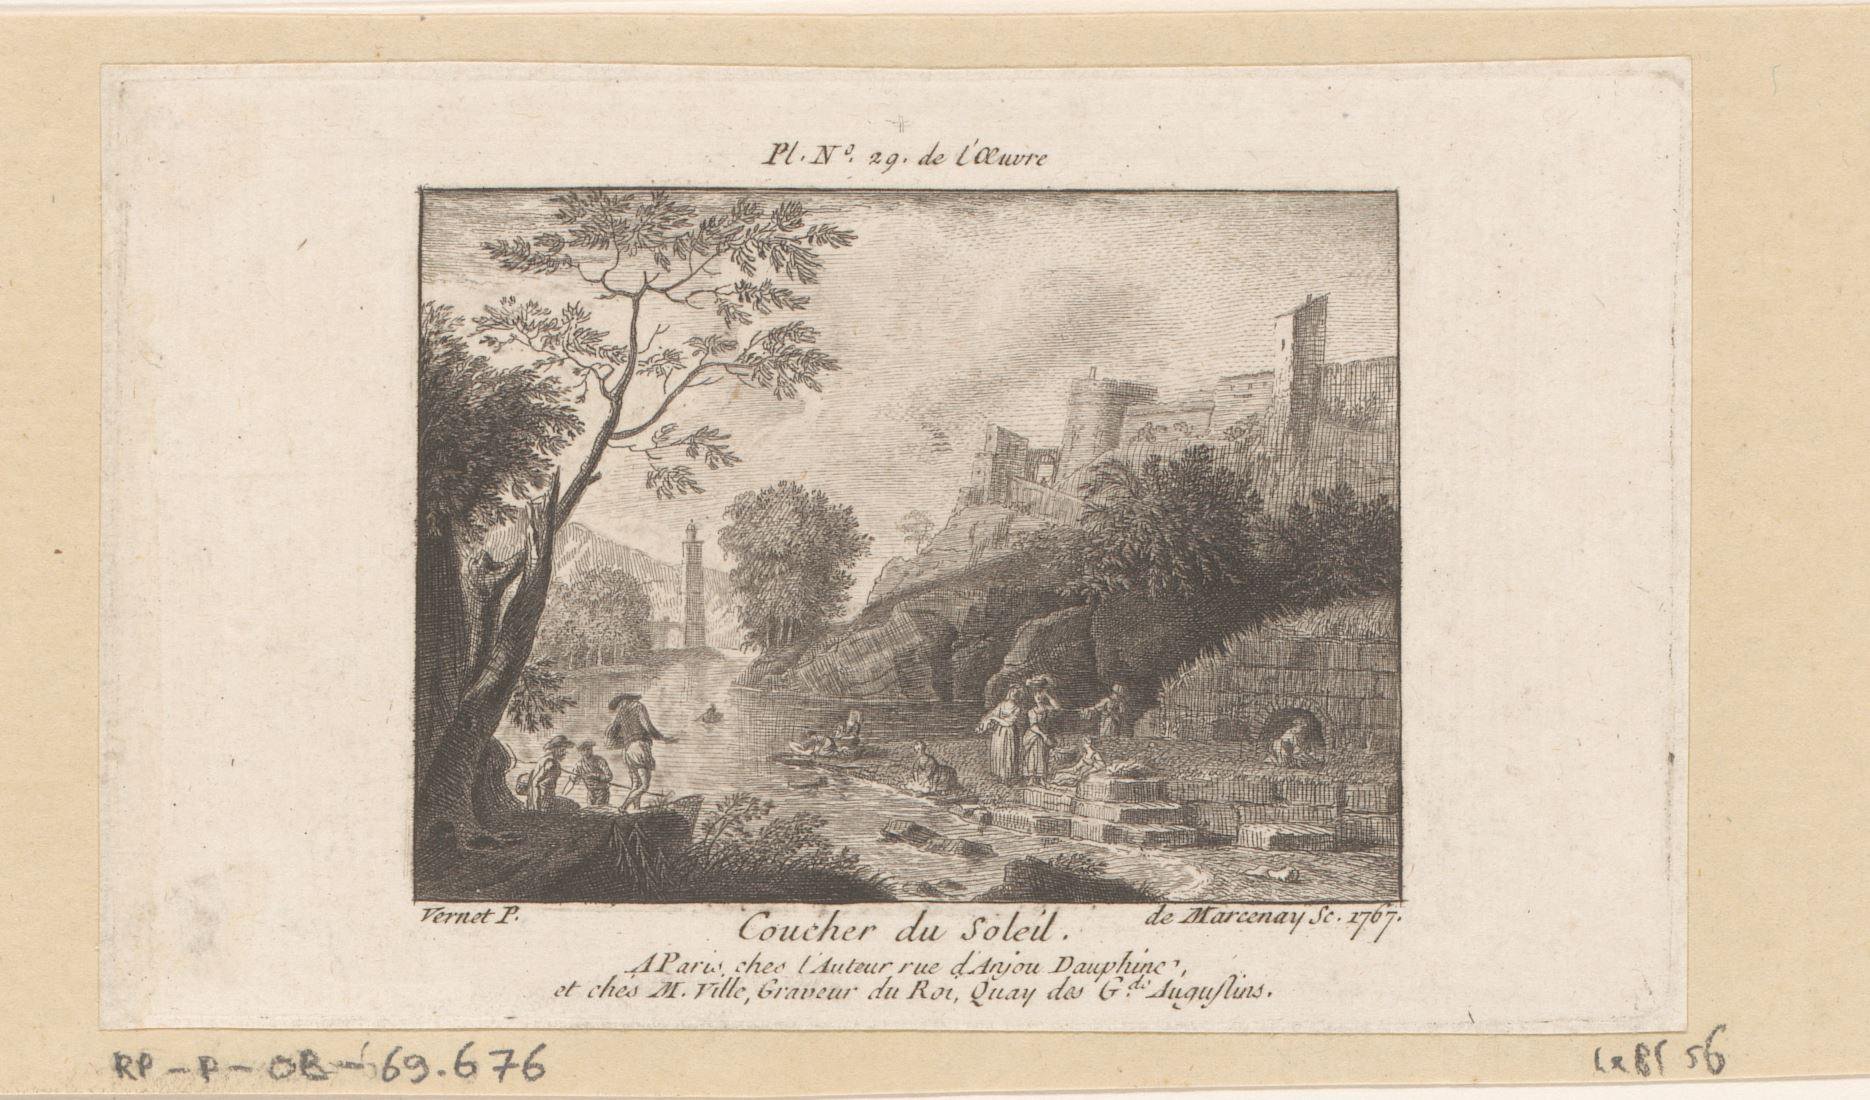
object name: print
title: Rivierlandschap met wasvrouwen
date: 1767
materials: paper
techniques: etching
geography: paris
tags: river, laundering, sunset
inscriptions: collector's mark: Lugt 2228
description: Genummerd midden boven: Pl. No. 29. de l'Oeuvre.